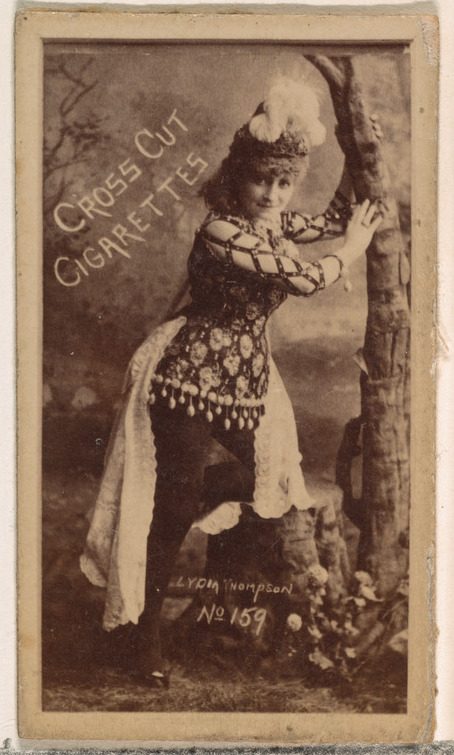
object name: print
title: Card Number 159, Lydia Thompson, from the Actors and Actresses series (N145-1) issued by Duke Sons & Co. to promote Cross Cut Cigarettes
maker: w. duke, sons & co.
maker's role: publisher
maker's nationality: american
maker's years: 1870-1920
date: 1880-1889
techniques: albumen silver print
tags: portraits,women,actresses